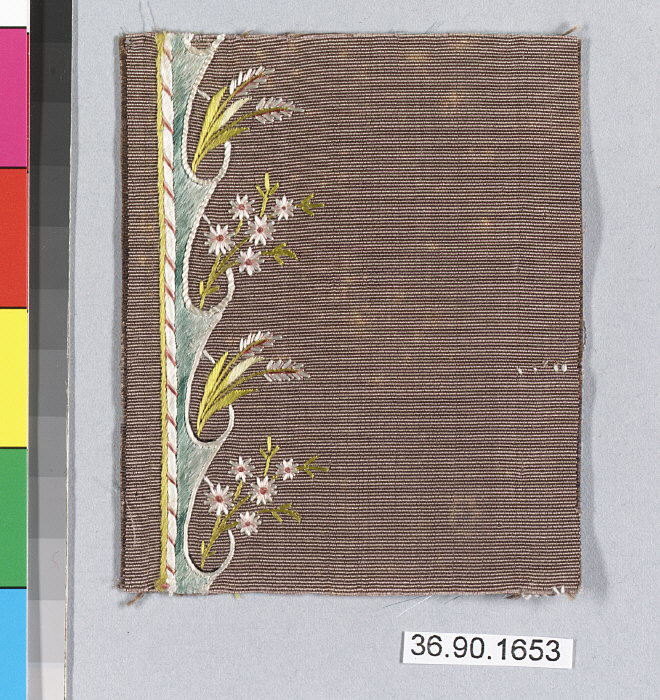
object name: sample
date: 1801-1833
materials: silk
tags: flowers